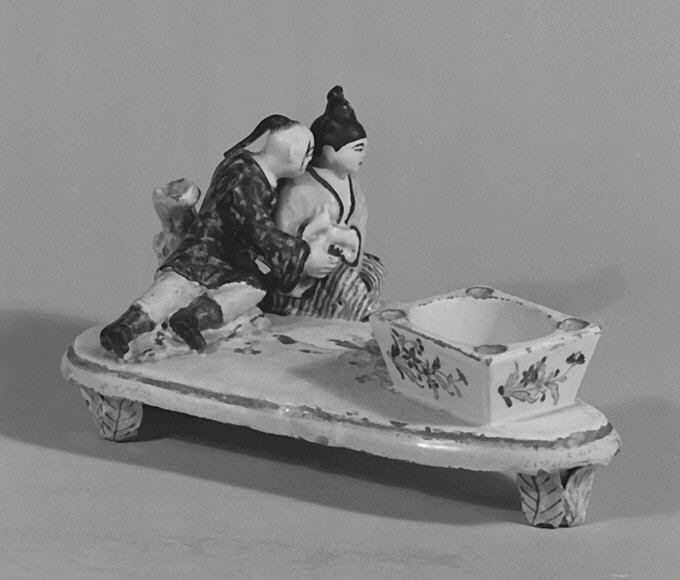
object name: inkstand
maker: johannes zeschinger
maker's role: decorator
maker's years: 1723-1823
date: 1701-1800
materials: earthenware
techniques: glazing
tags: men,women